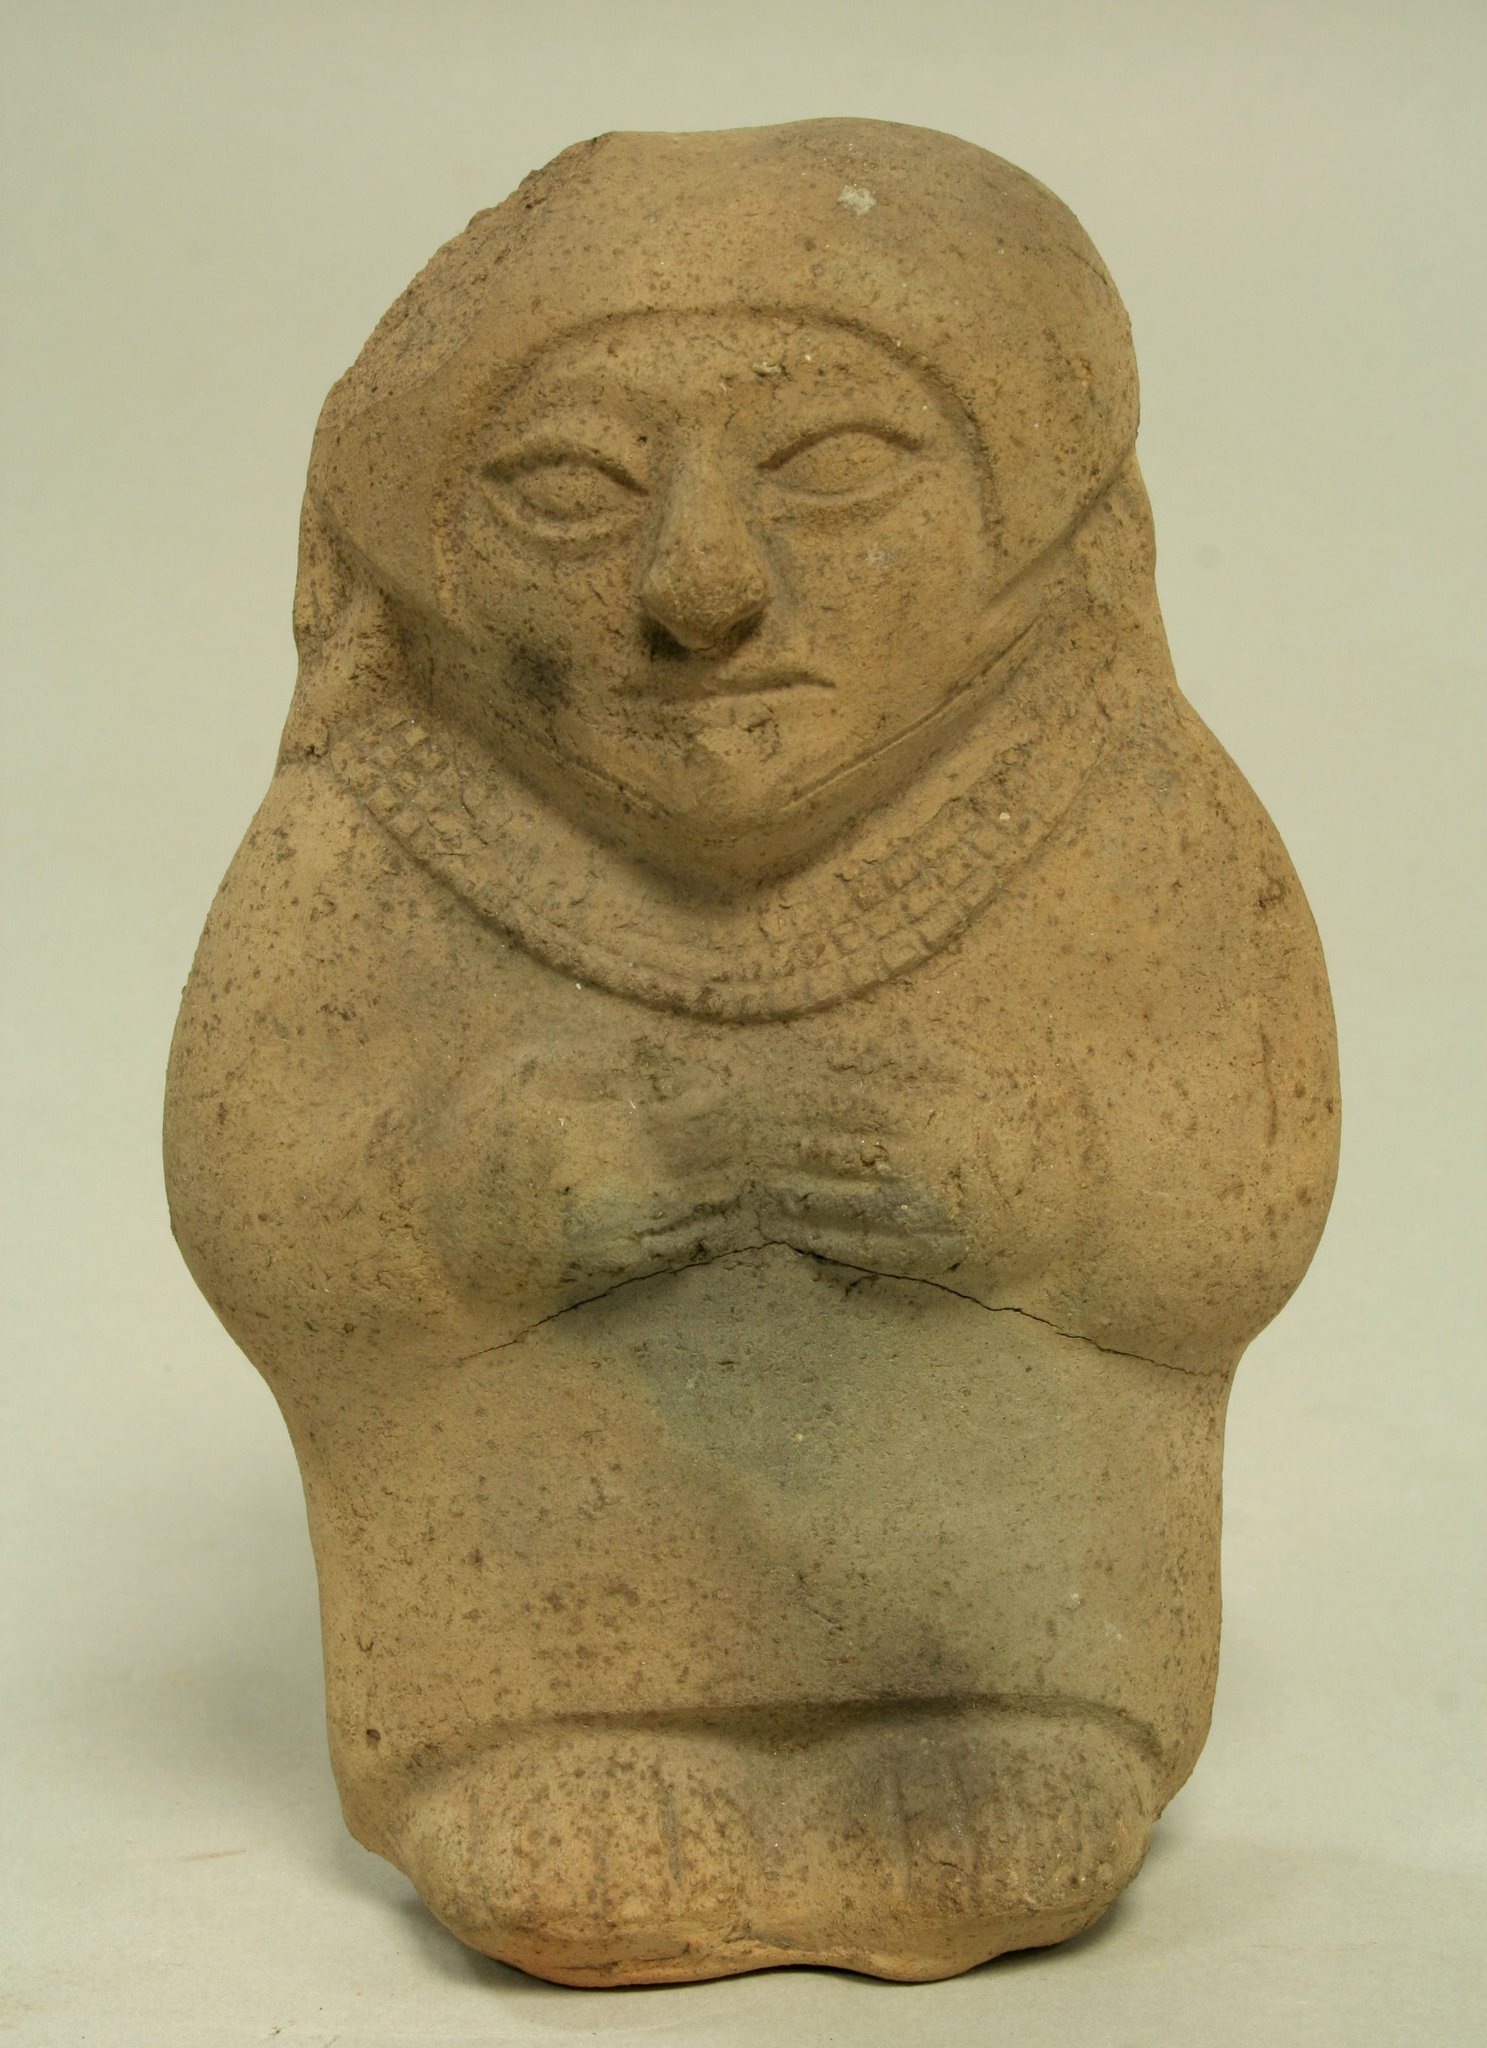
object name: figure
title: Standing Ceramic Figure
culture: moche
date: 201-500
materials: ceramic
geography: peru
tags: human figures